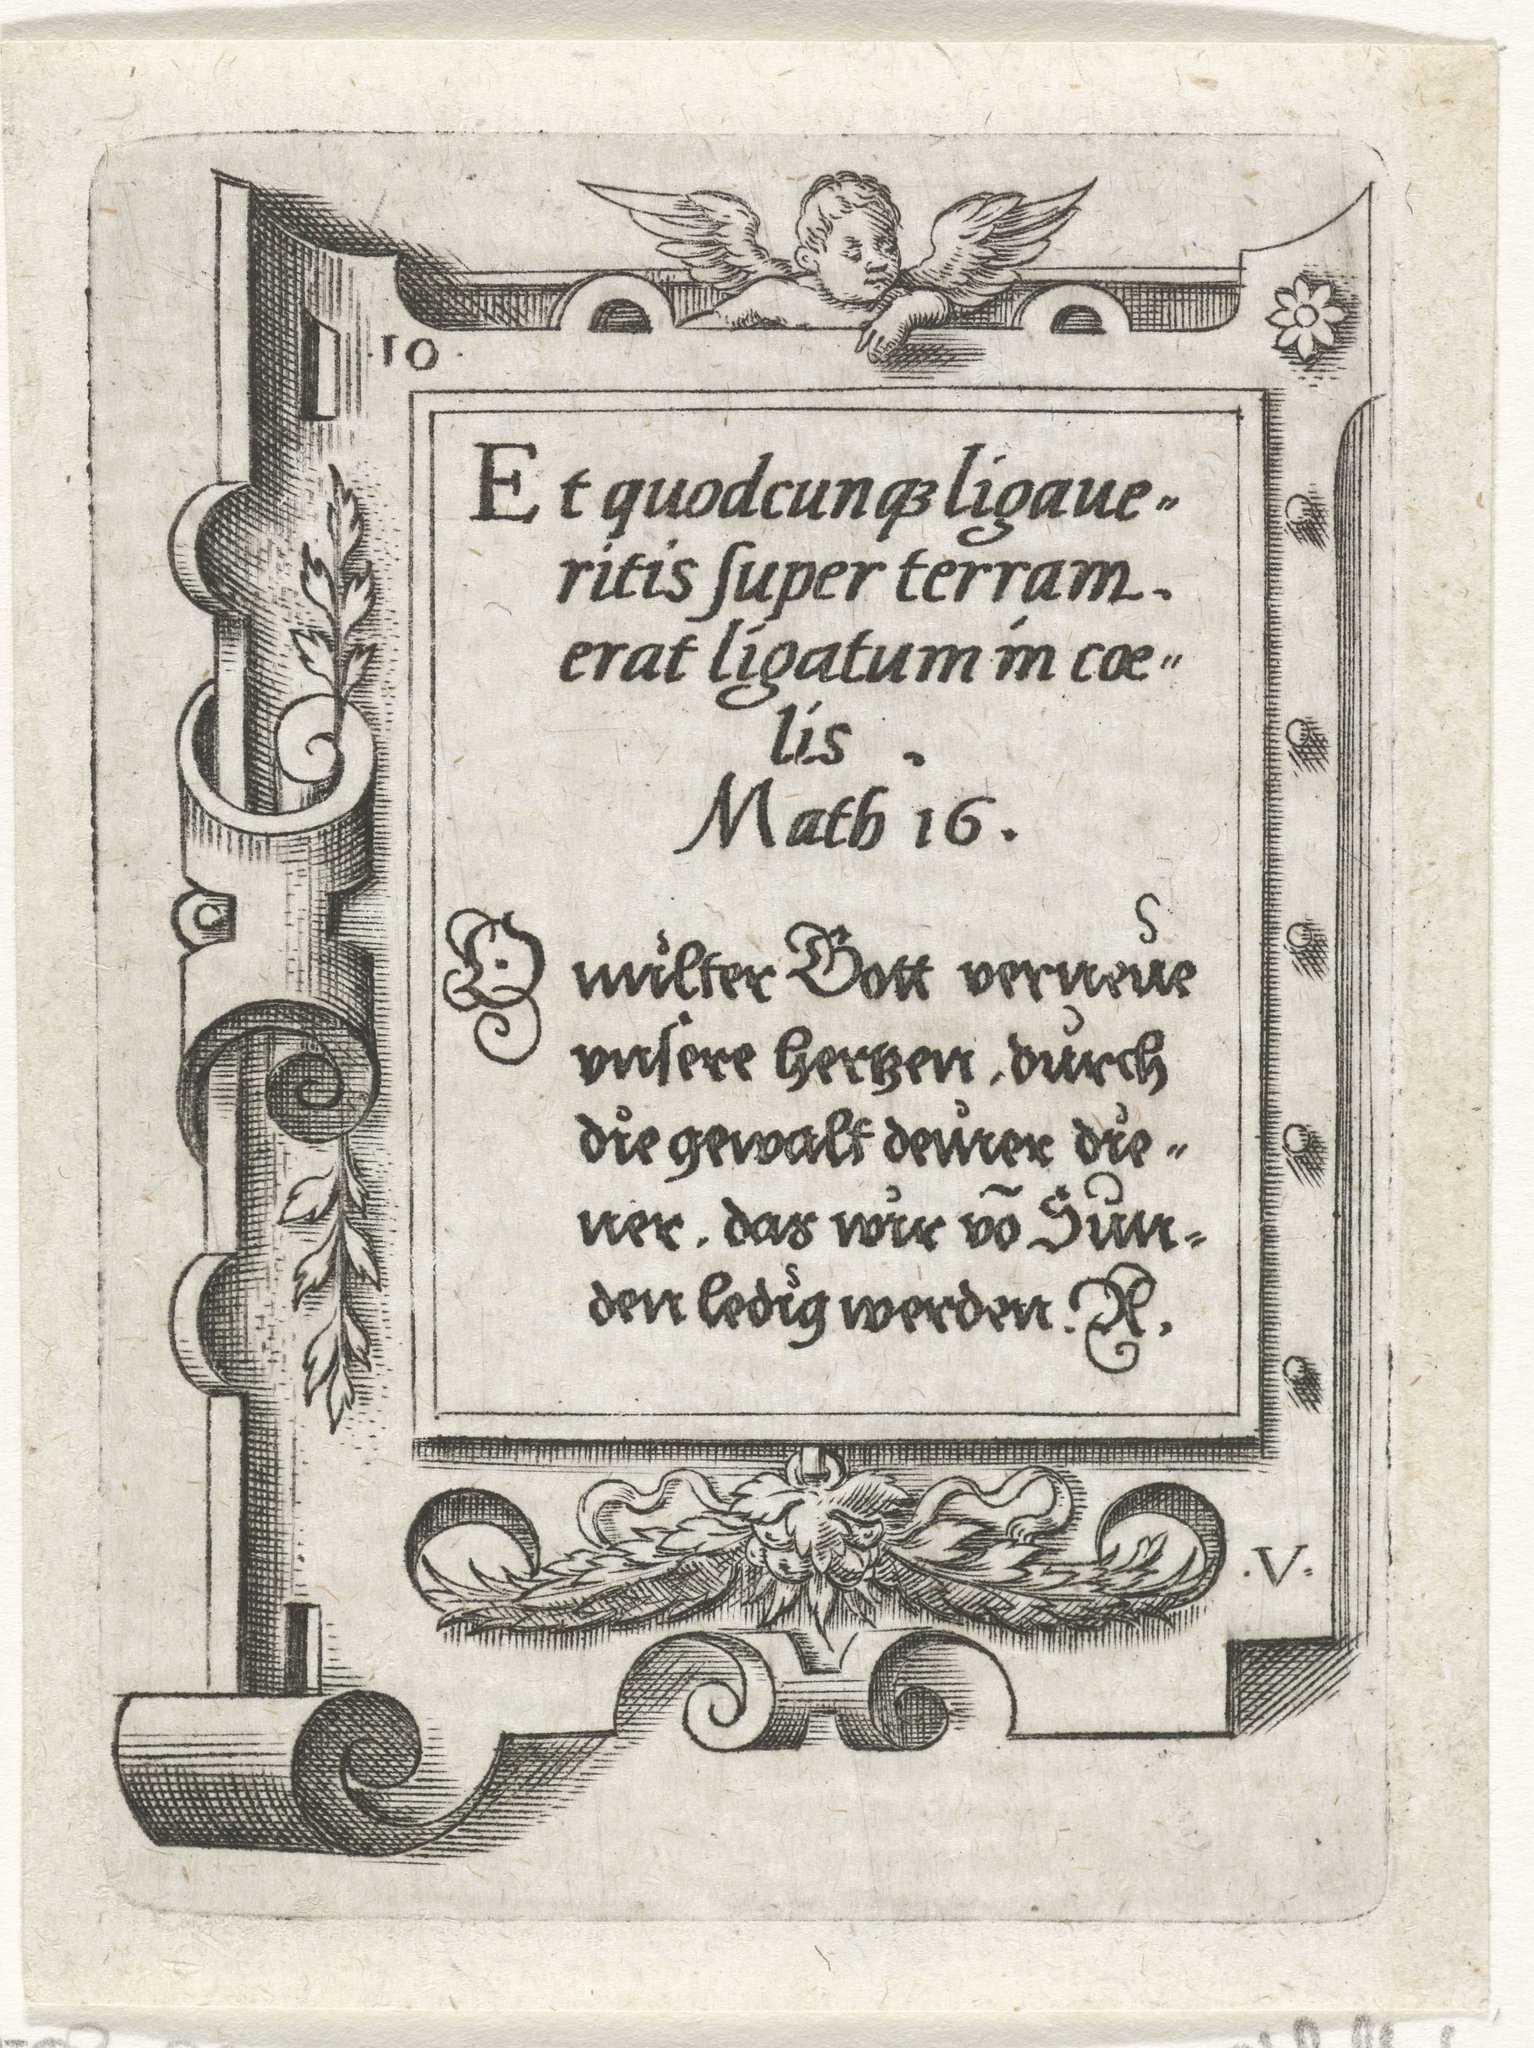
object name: print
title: Tekst: Et quod (...)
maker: virgilius solis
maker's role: draughtsman, print maker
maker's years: 1514-1562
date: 1524-1562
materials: paper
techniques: engraving